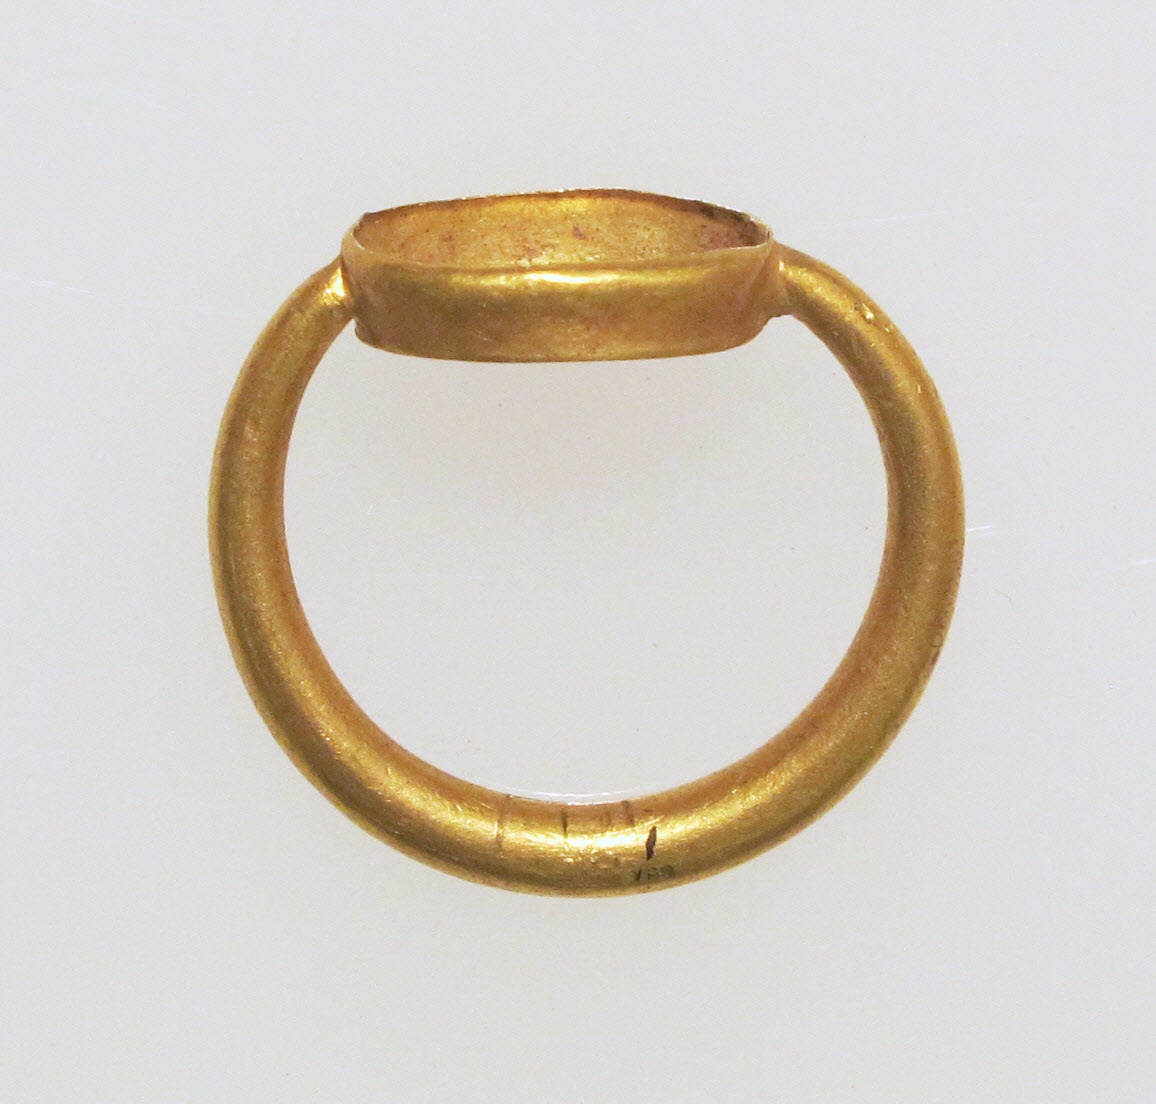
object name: ring with box setting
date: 7000 BCE-330 CE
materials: gold